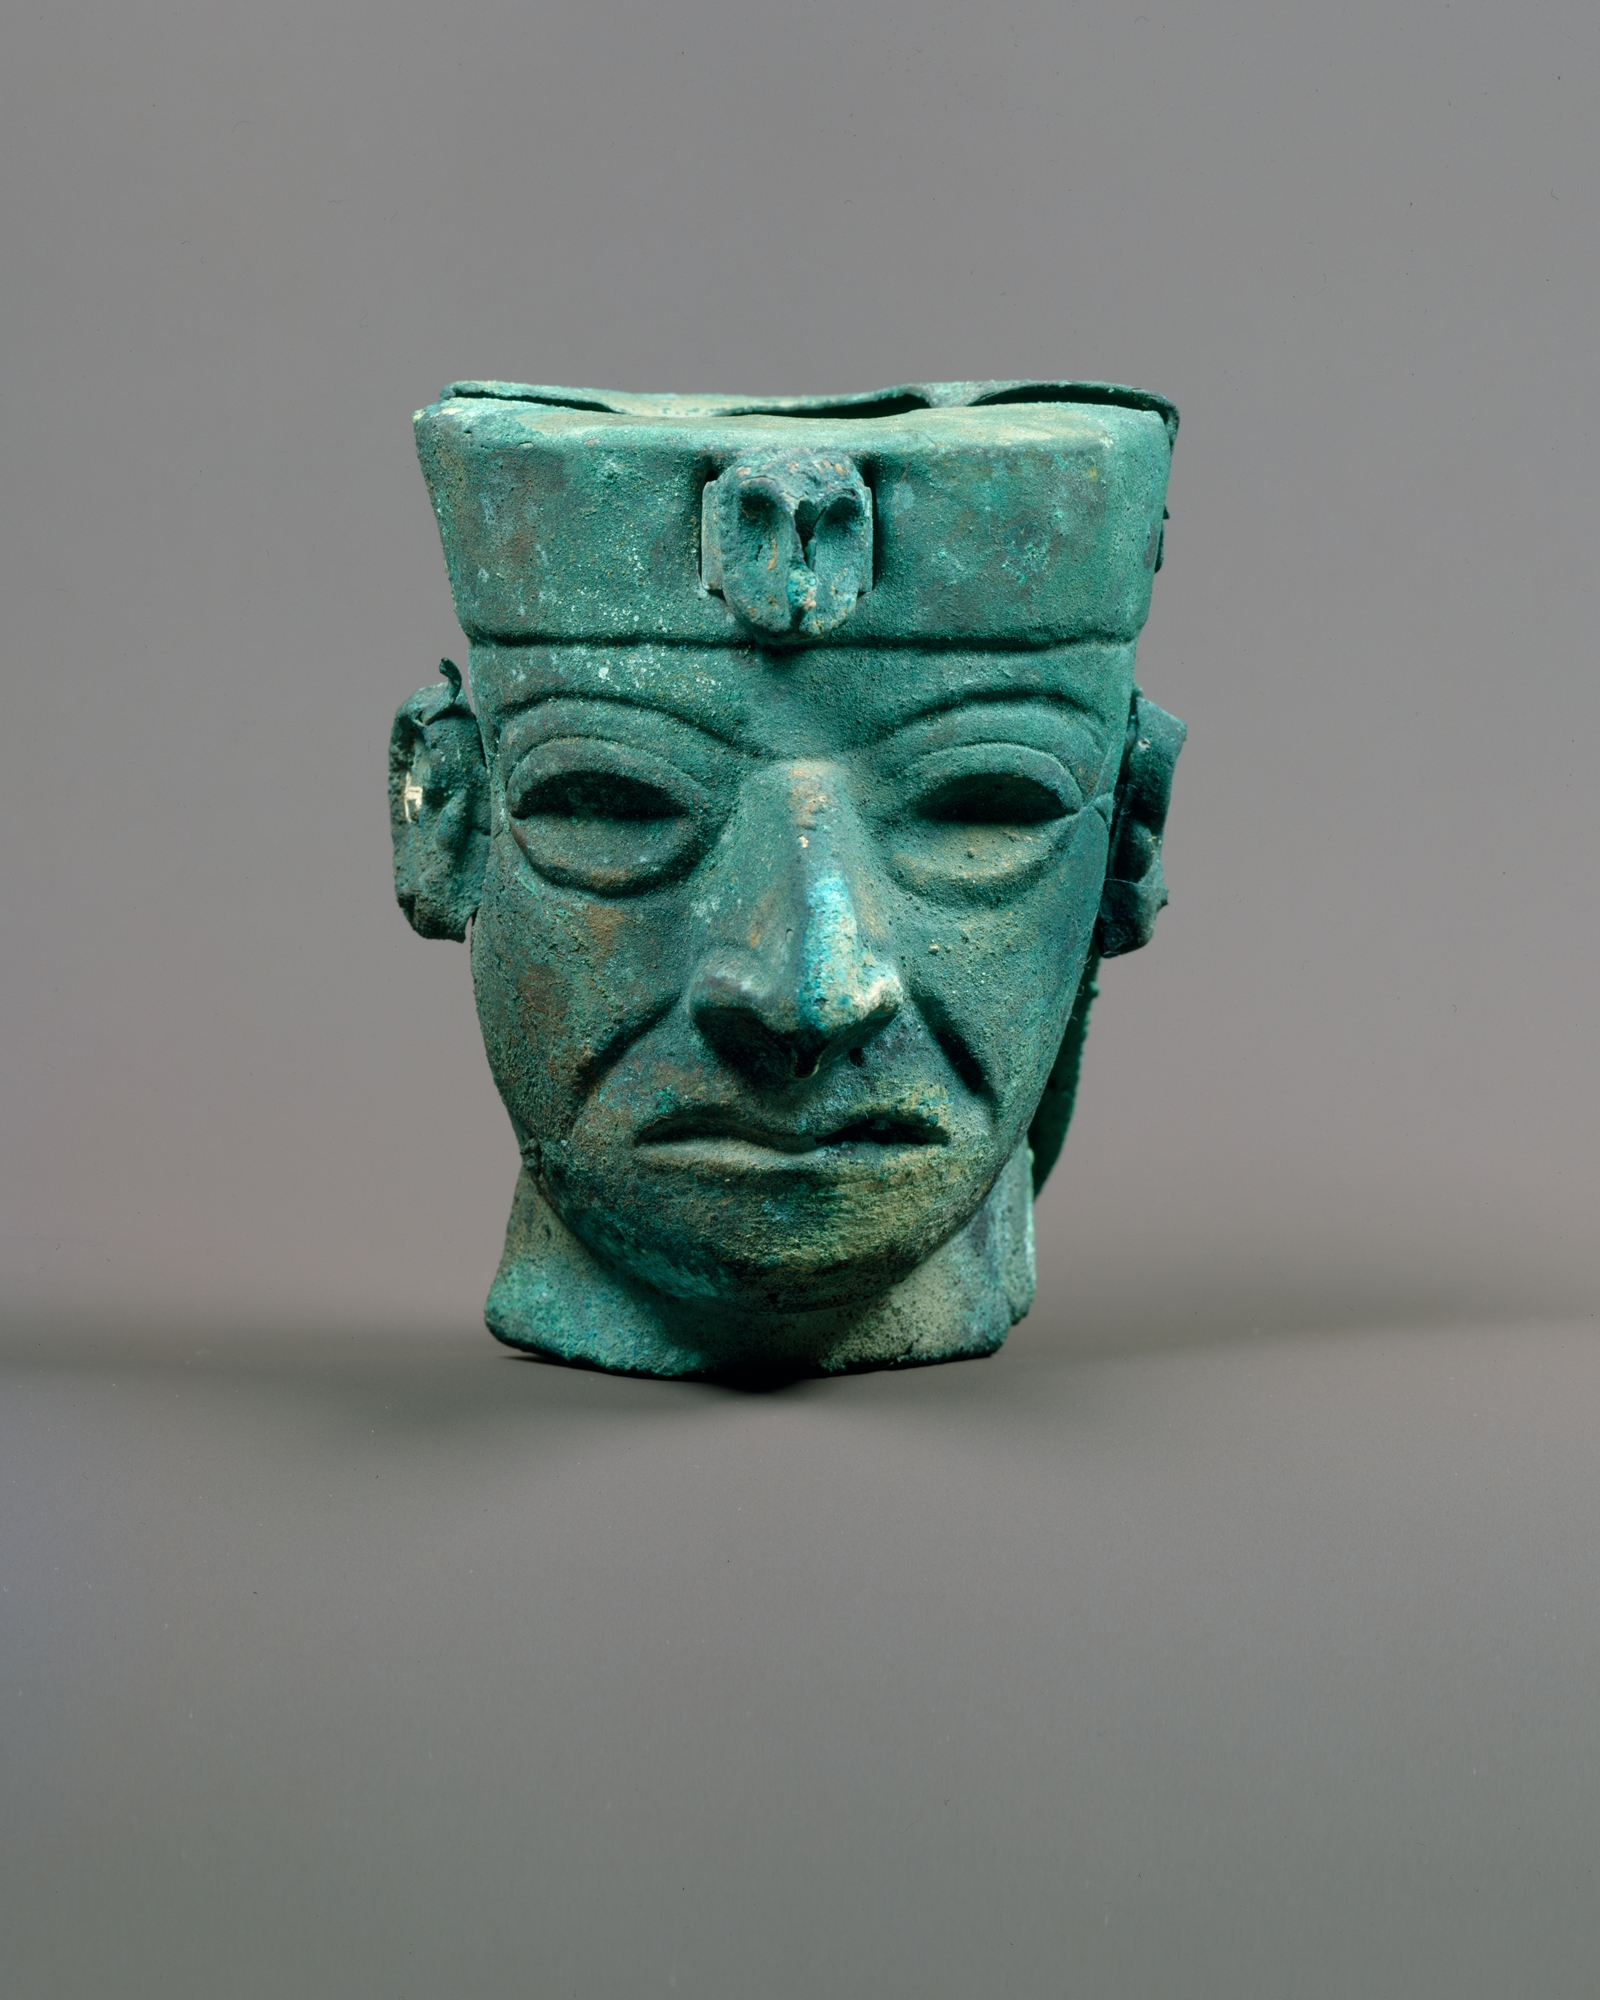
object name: ornament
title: Head ornament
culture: moche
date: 501-700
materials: gilt copper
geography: peru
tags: faces